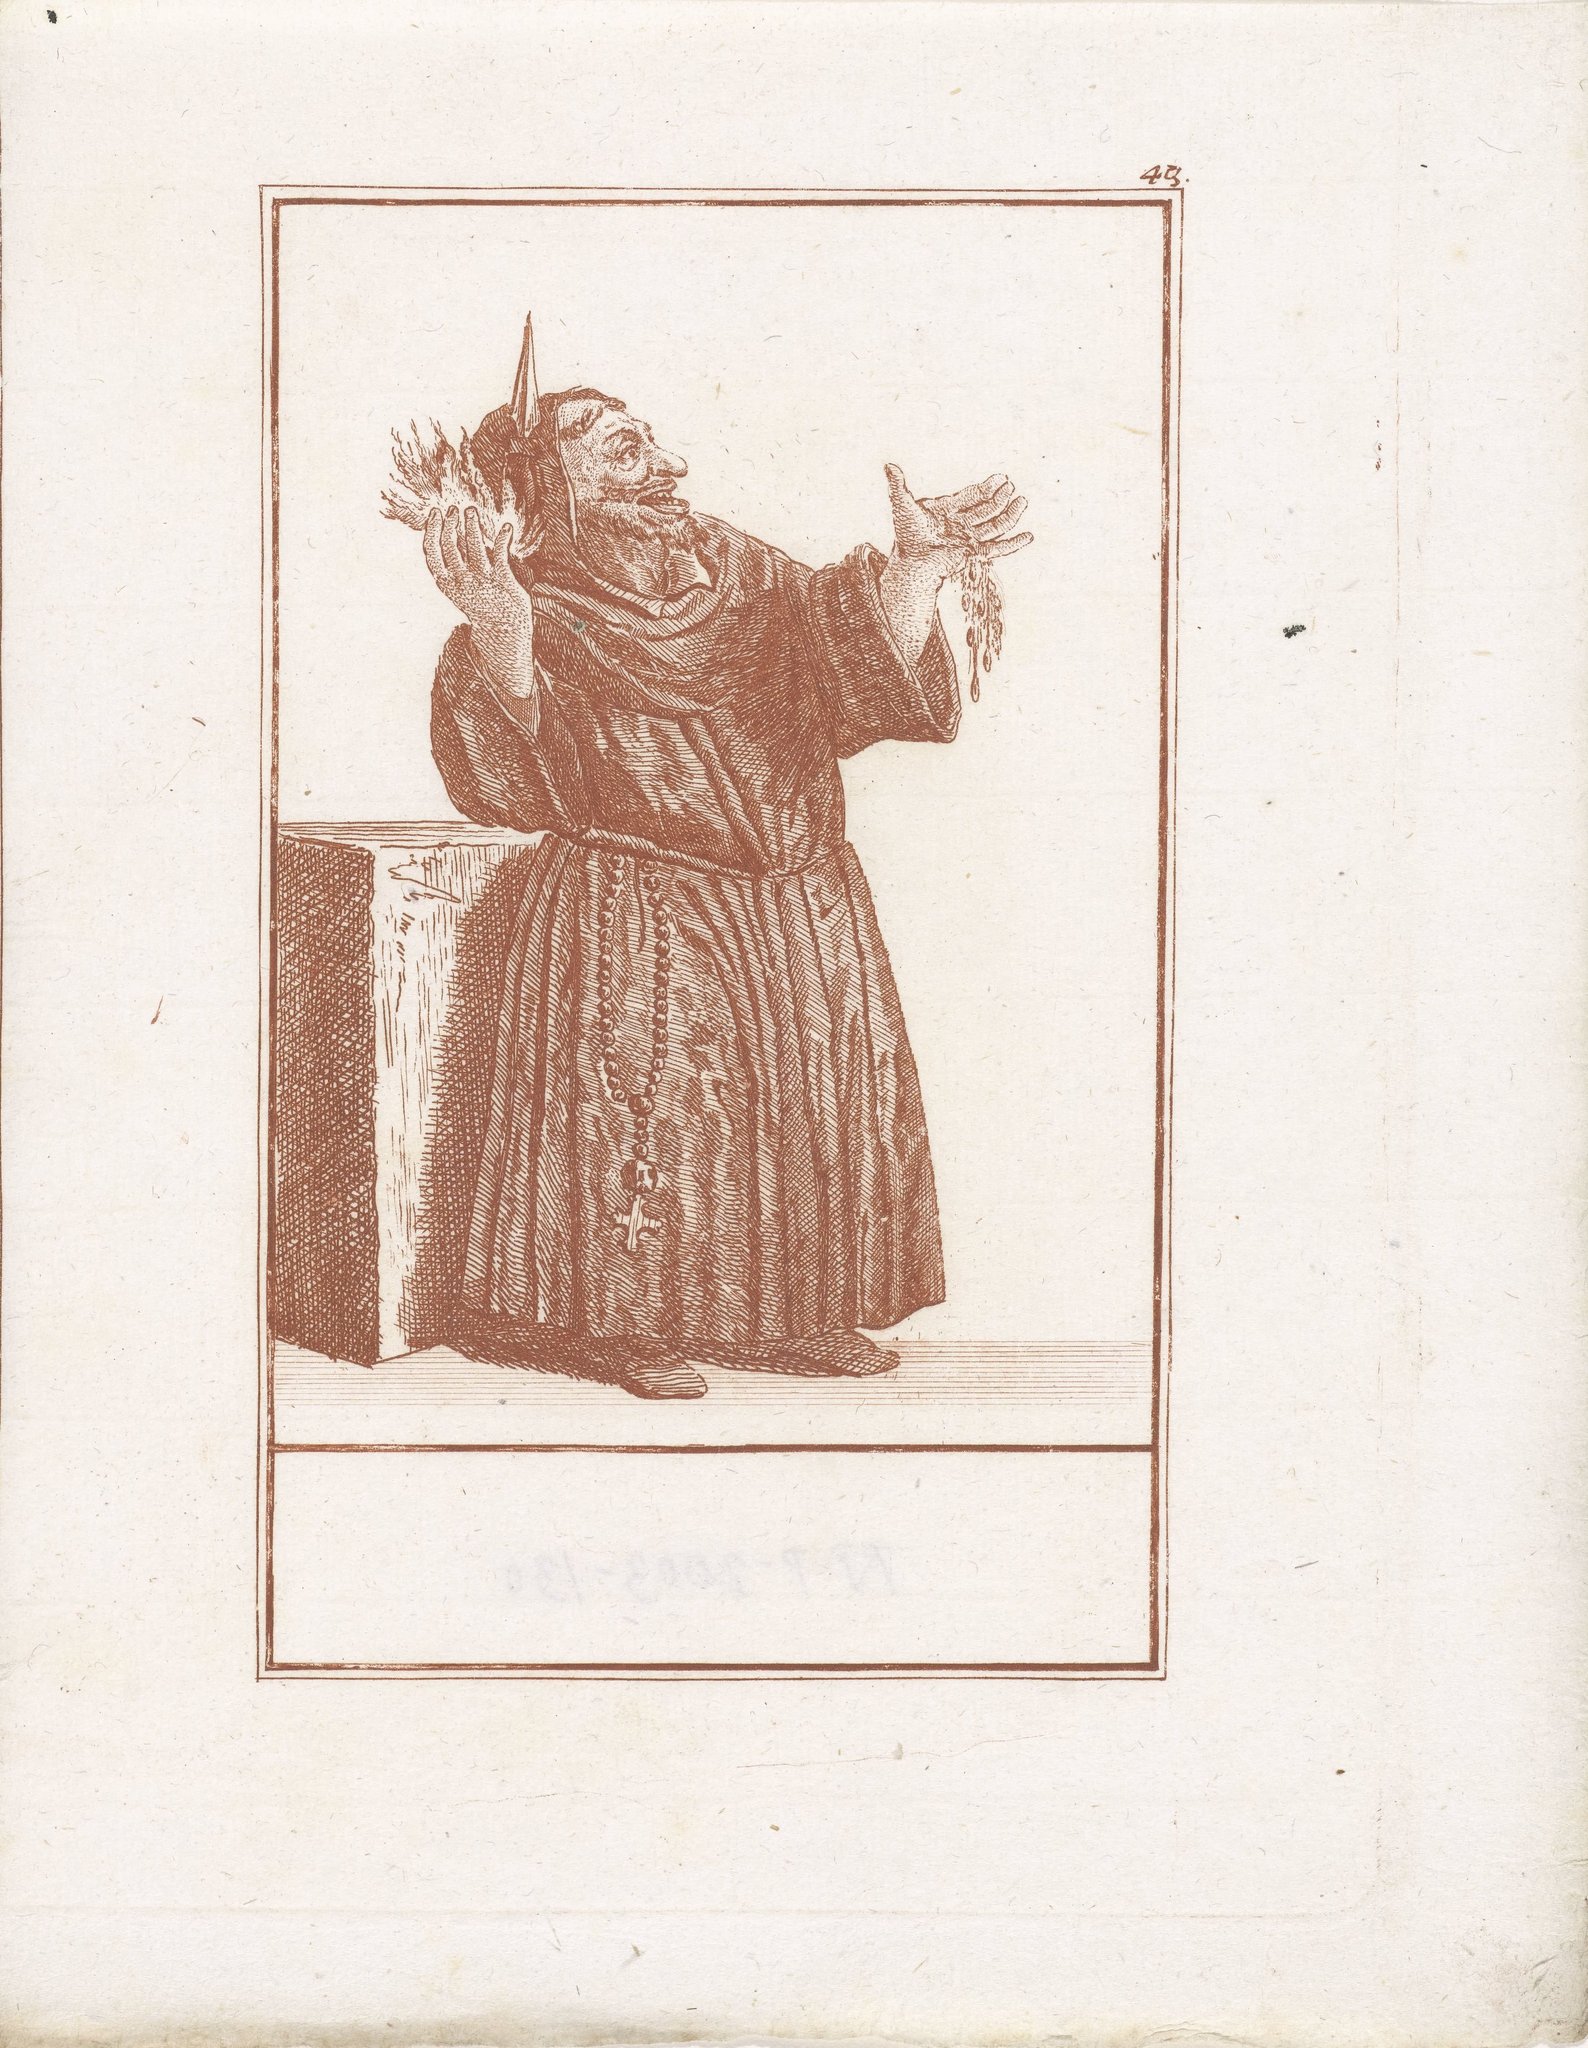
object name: cartoon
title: Monnik met vuur in de ene, water in de andere hand.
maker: jacob gole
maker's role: print maker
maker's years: 1660-1724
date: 1724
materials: paper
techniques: etching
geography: amsterdam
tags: water (one of the four elements), fire (one of the four elements), monk(s), friar(s), (aspects of) christian religion or the church (as institution) ridiculed, criticized, or caricaturized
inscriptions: collector's mark: Lugt 2760, collector's mark: Lugt 2228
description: Een monnik, staande voor een blok. Hij houdt beide handen met de palmen omhoog. In zijn rechterhand vuur, uit zijn linkerhand stroomt water. De prent is deel van een 50-delige serie met als onderwerp de misbruiken van de katholieke geestelijkheid.